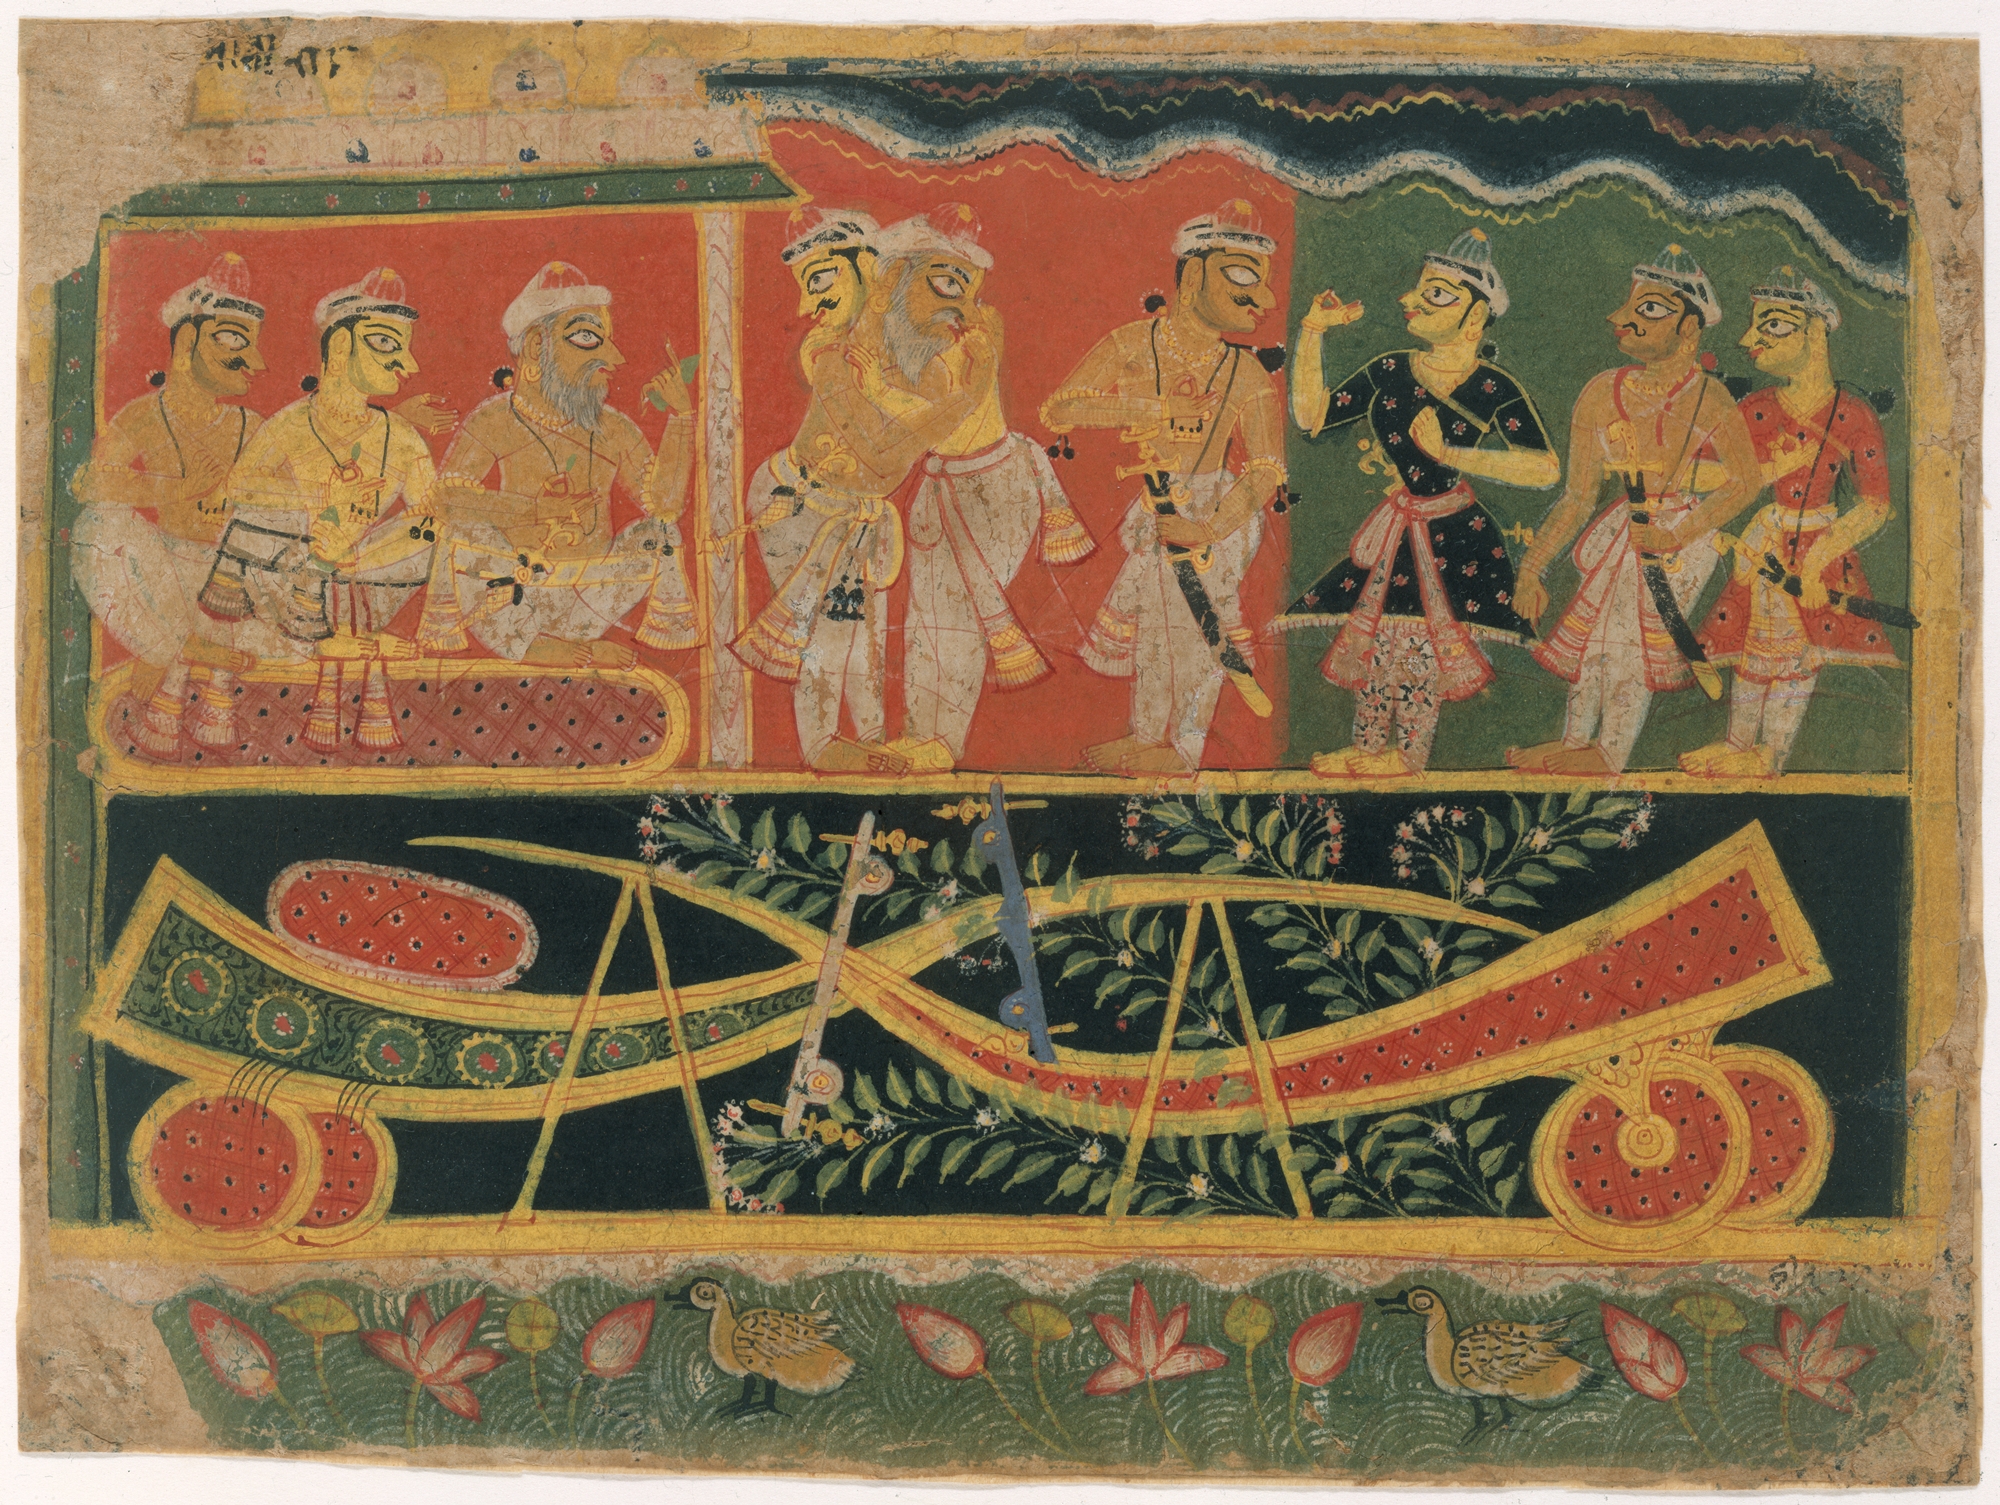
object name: folio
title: Nanda and Vasudeva: Page from a Dispersed Bhagavata Purana (Ancient Stories of Lord Vishnu)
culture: indian, delhi-agra area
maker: master of the dispersed bhagavata purana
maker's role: artist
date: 1520-1530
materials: ink, paper, watercolor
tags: ducks,men,wagons